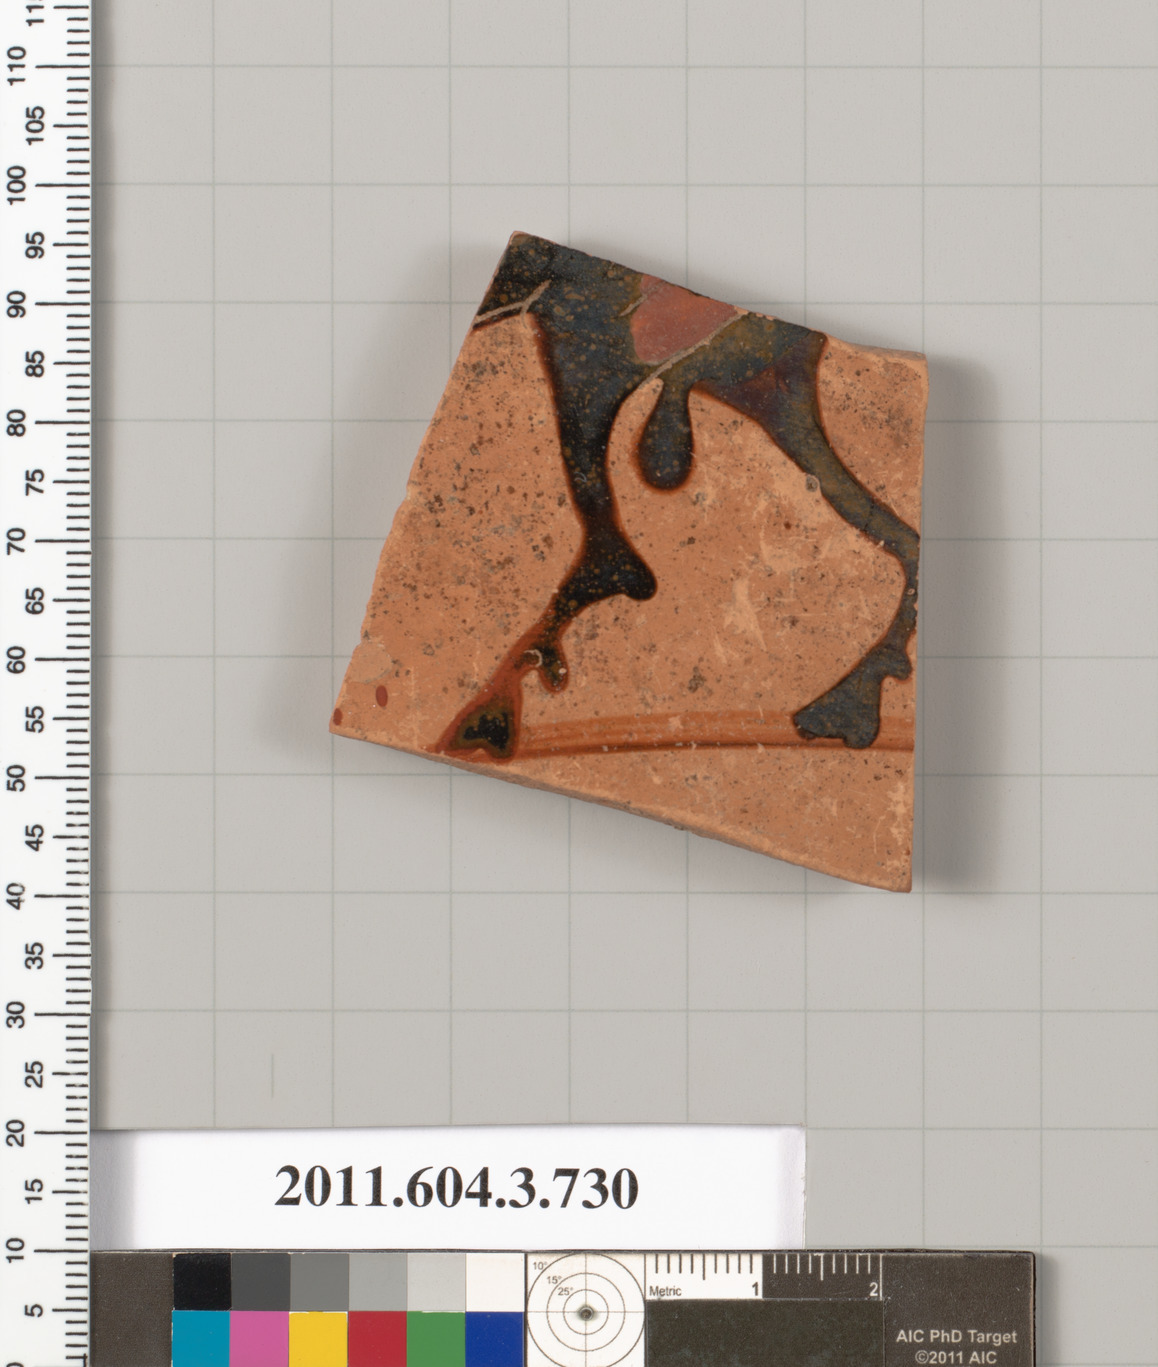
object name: neck amphora, tyrrhenian fragment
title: Terracotta fragment of a neck-amphora (jar)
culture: greek, attic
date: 575-551 BCE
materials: terracotta